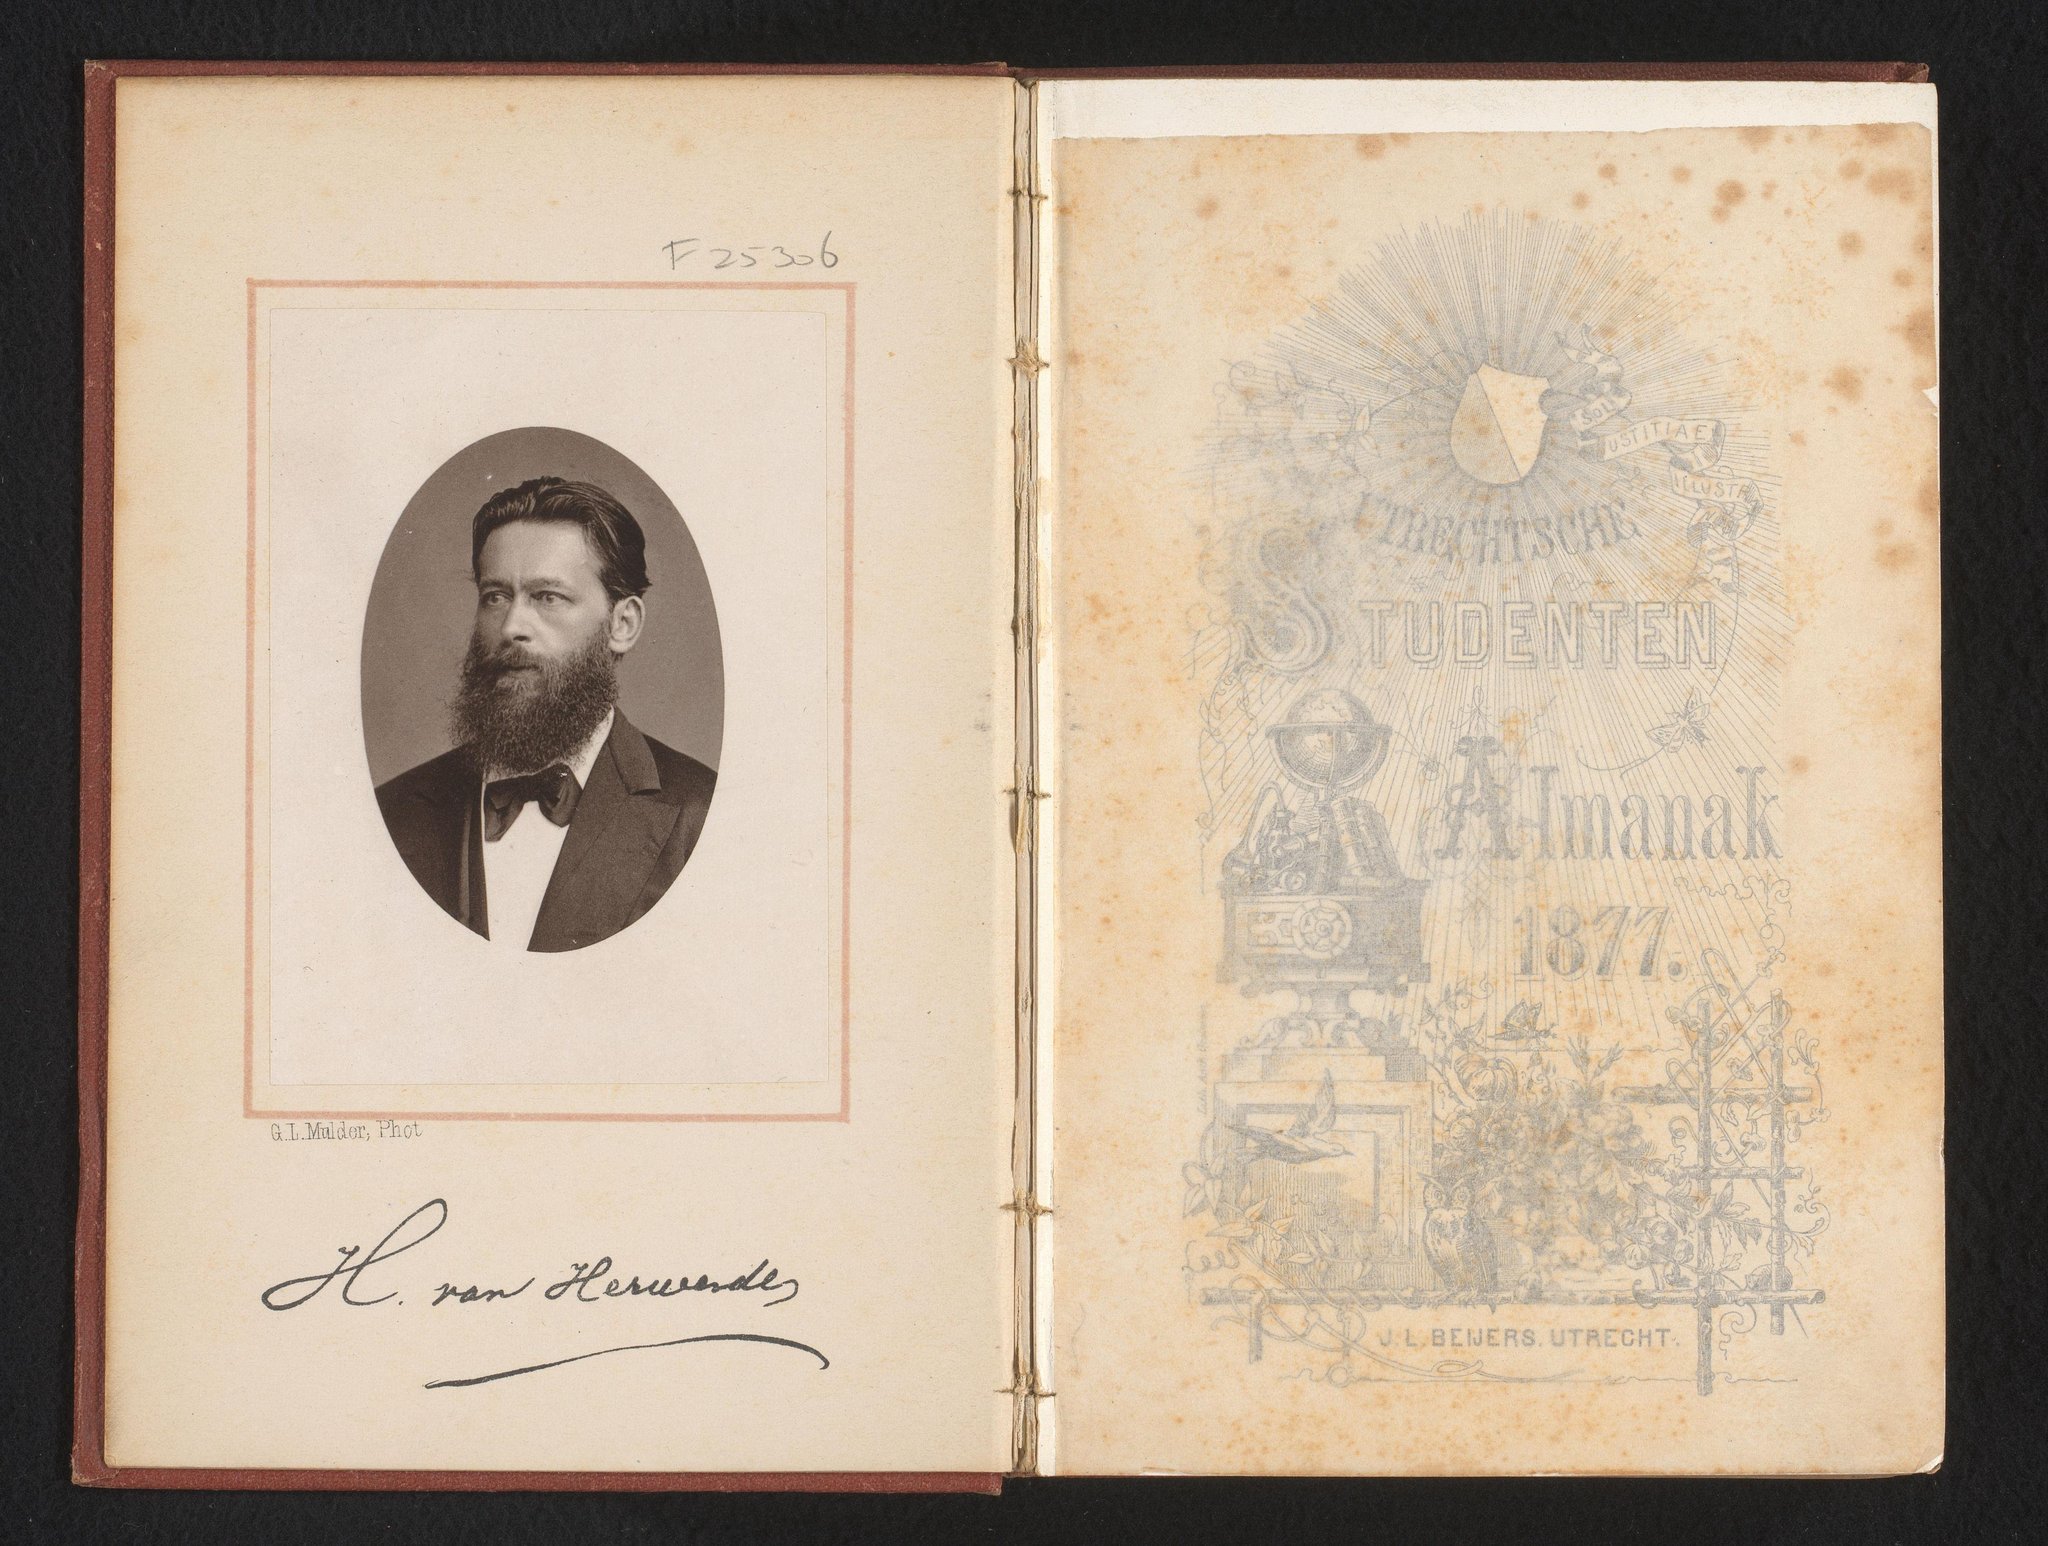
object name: page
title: Portret van Hendrik van Herwerden, hoogleraar wijsbegeerte en letteren en rector magnificus van de Universiteit Utrecht 1876-1877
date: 1875-1876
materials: paper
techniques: photograph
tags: haarlem, historical persons, professor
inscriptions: signature: ‘H. van Herwerden’